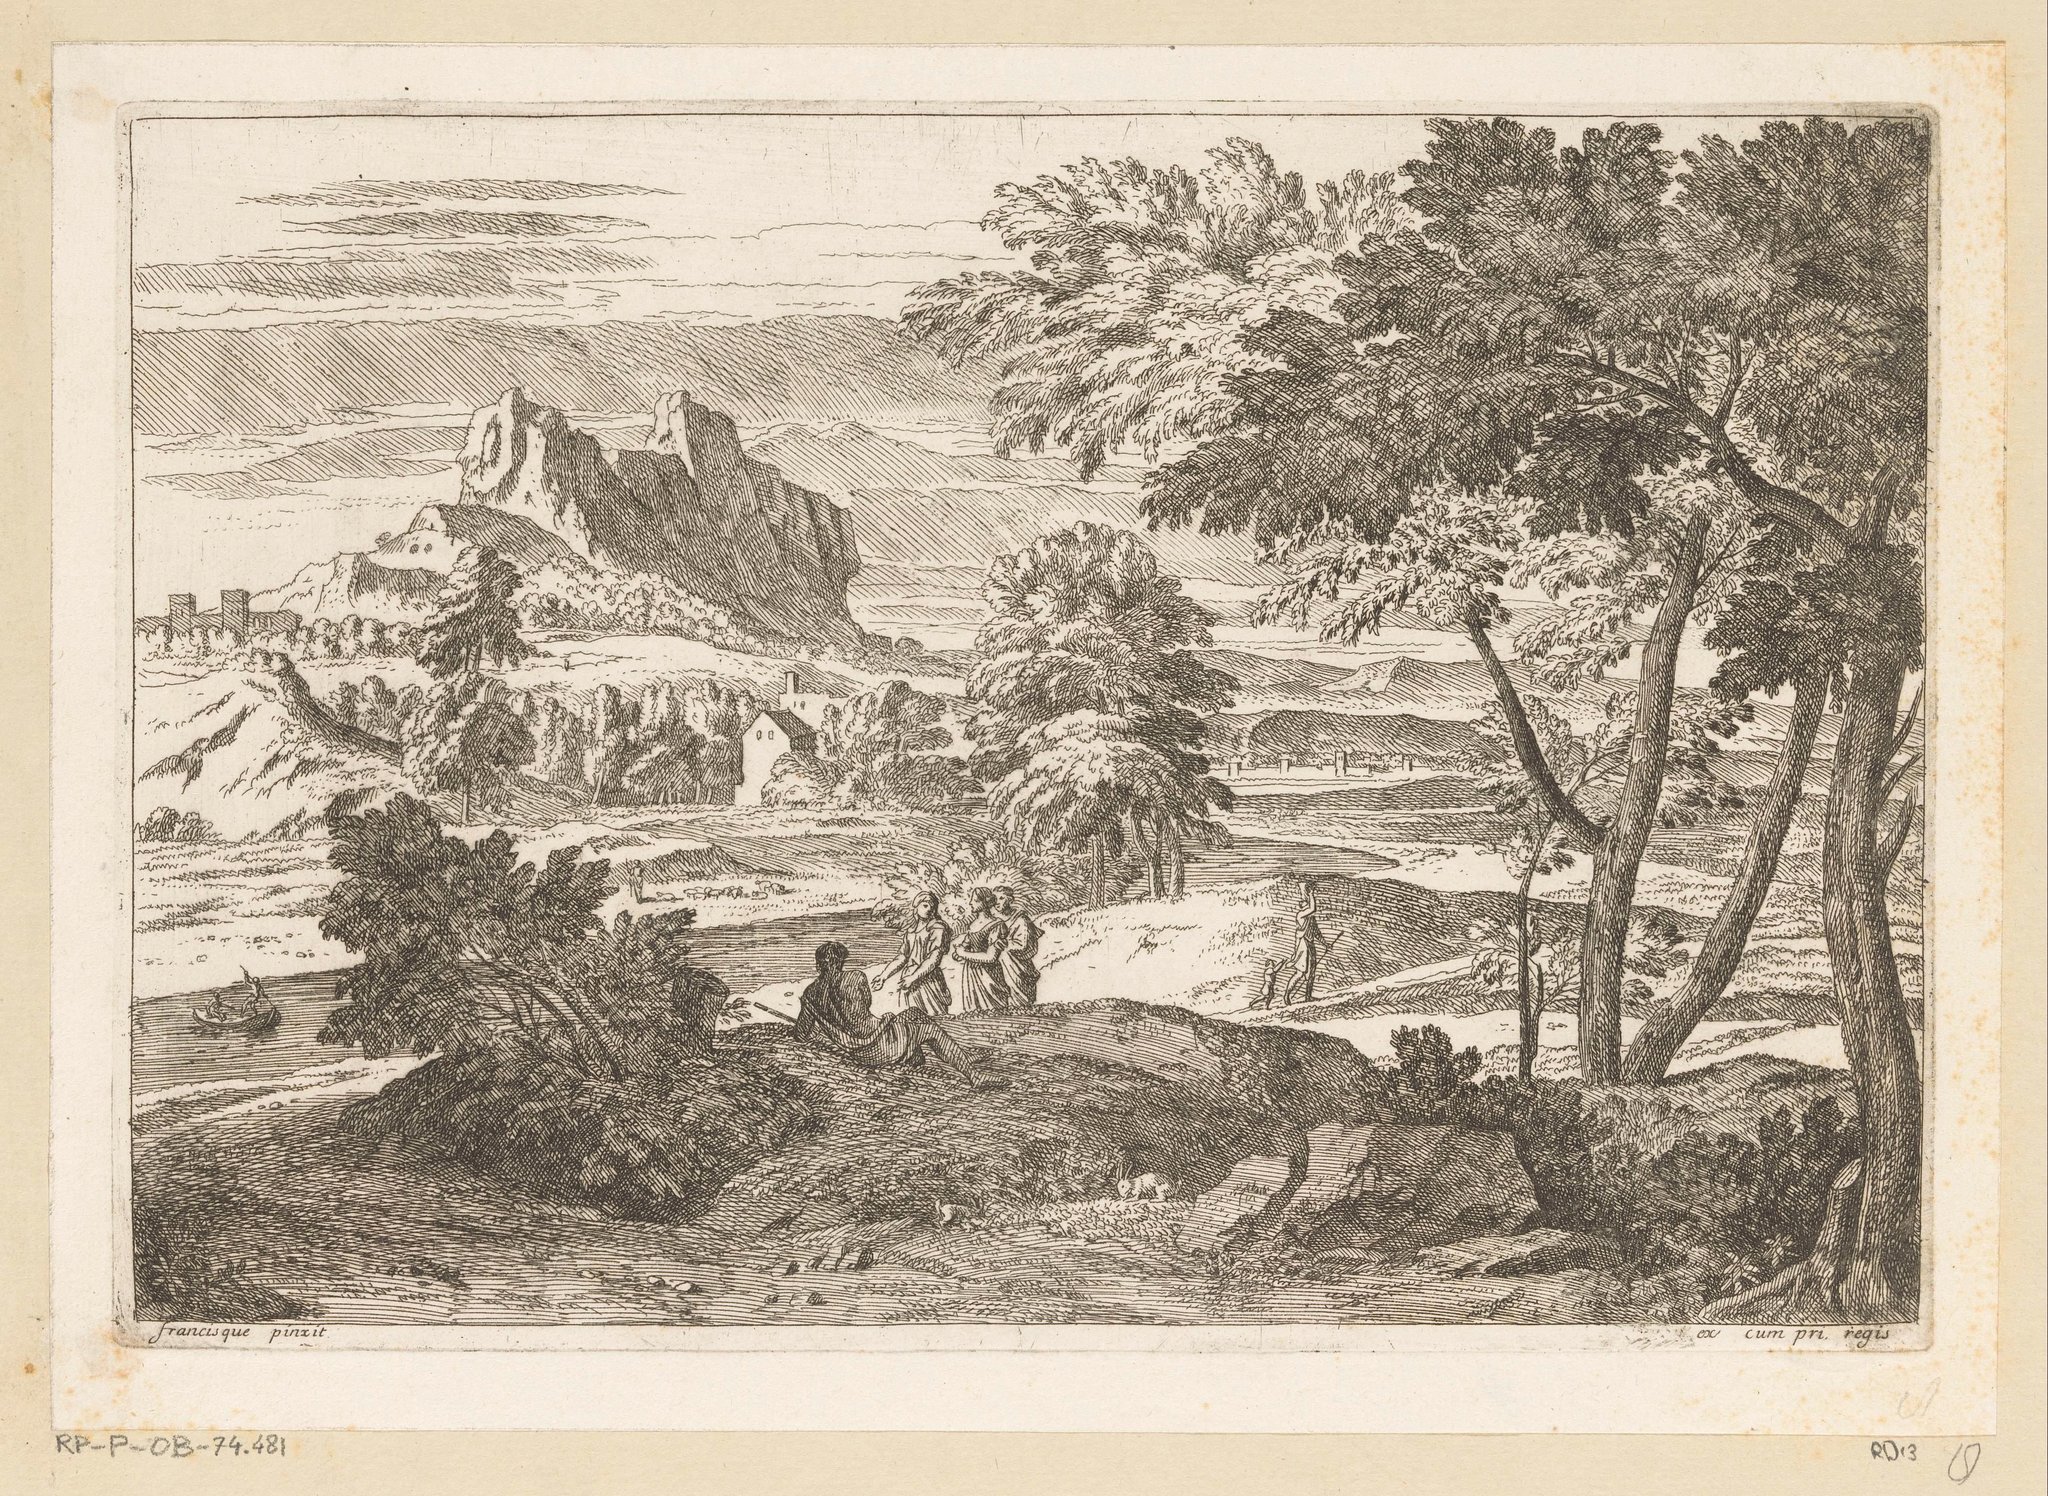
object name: print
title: Suite de Paysages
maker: Anonymous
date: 1690-1730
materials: paper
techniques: etching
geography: france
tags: landscapes in the temperate zone - hh - ideal landscapes, trees, rodents: rabbit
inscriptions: collector's mark: Lugt 240